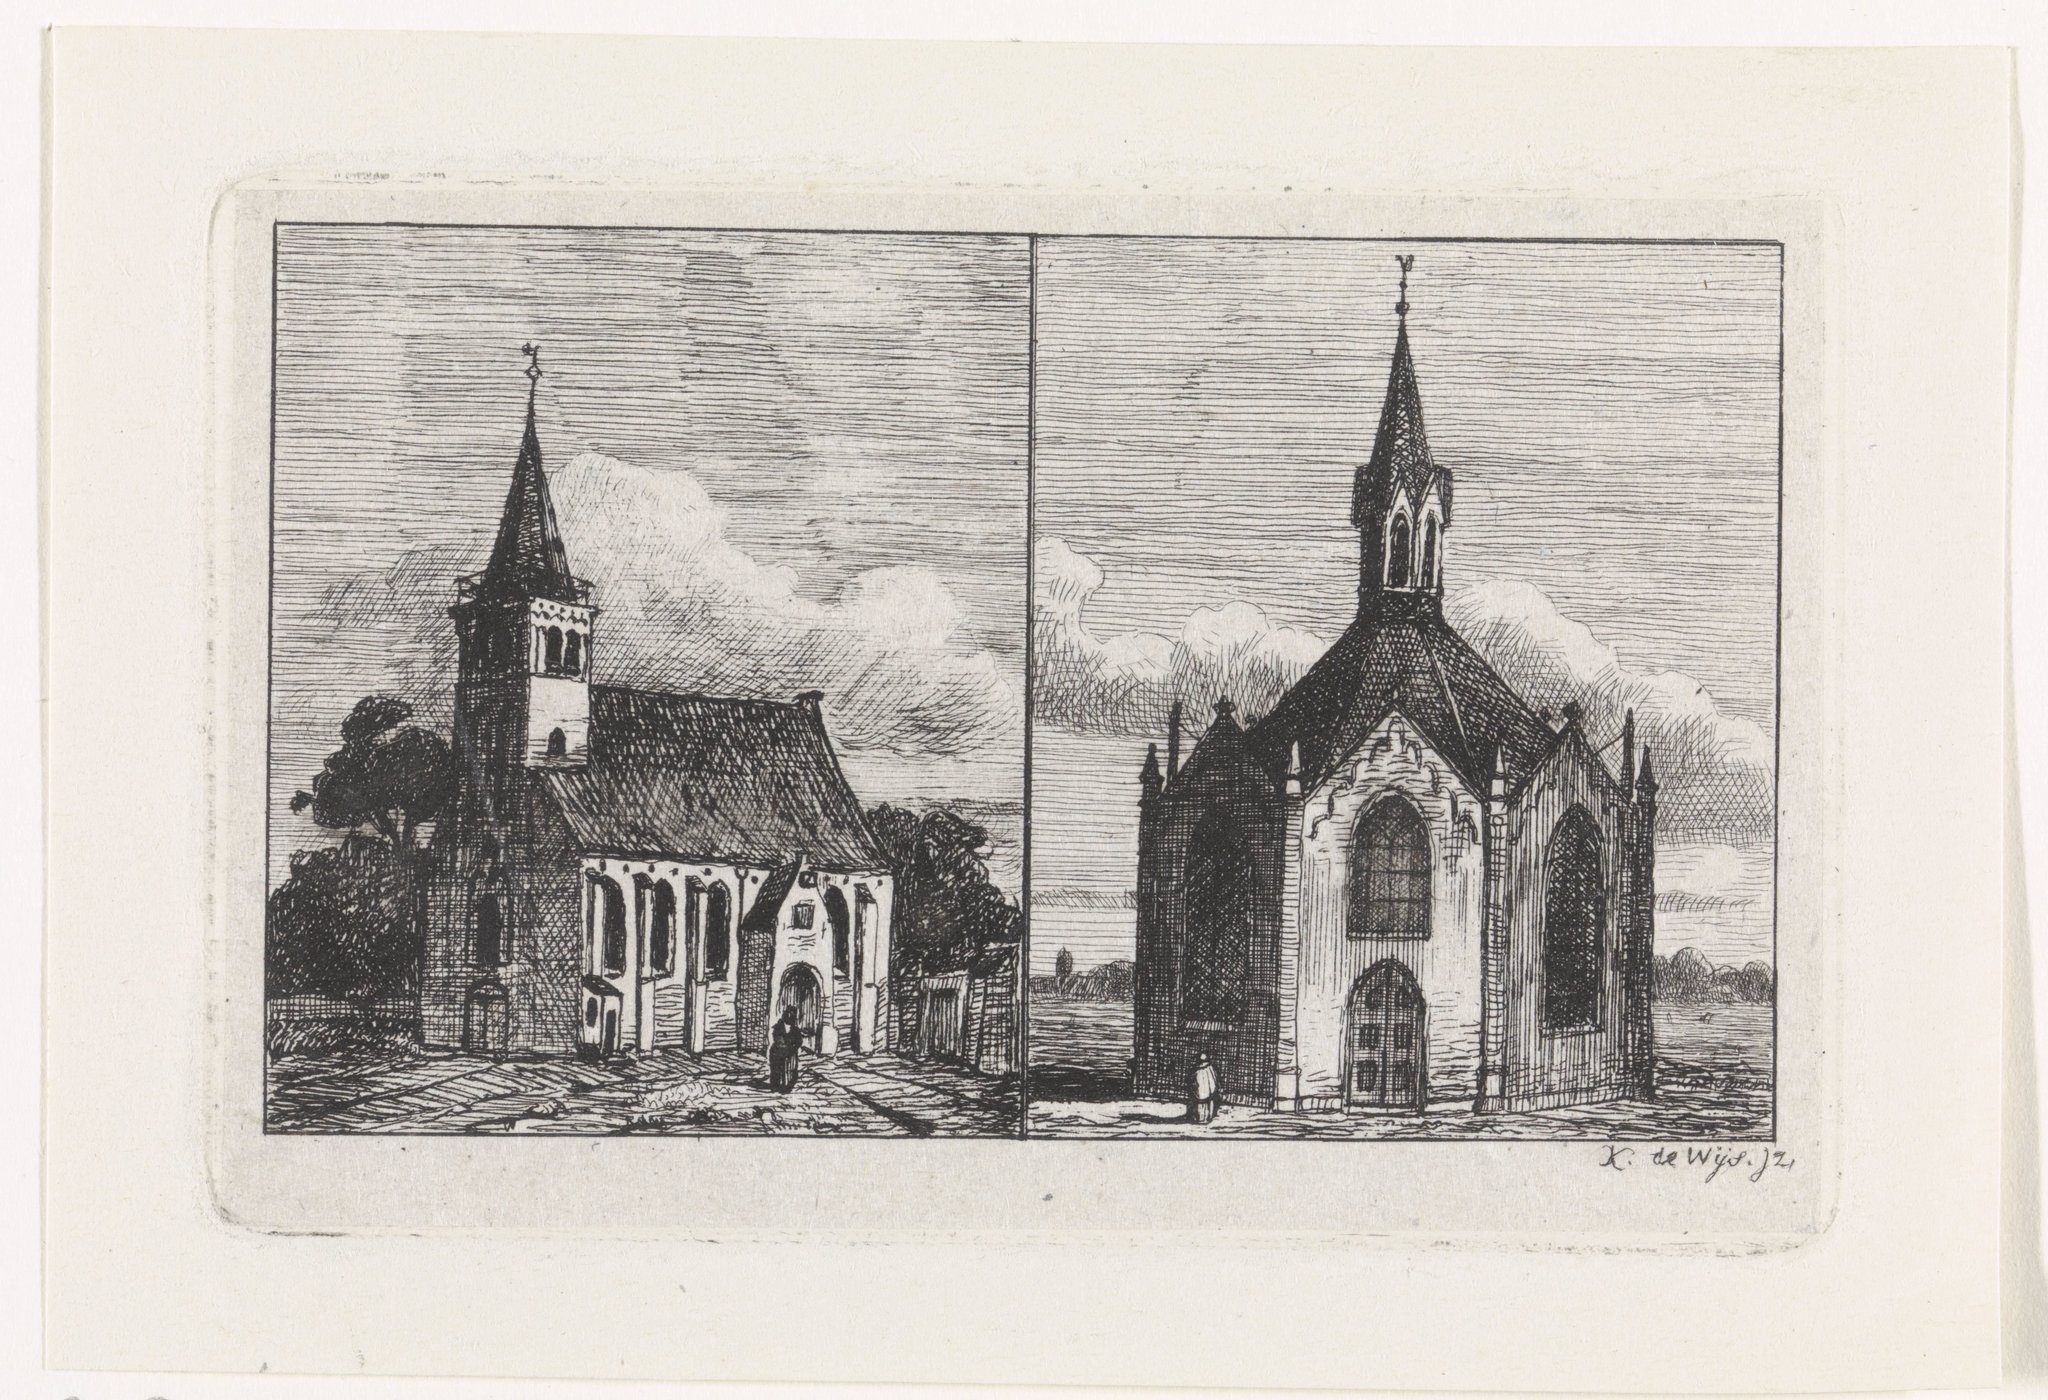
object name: print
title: Twee kerken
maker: kornelis jzn de wijs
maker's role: print maker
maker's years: 1832-1896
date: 1842-1884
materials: paper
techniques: etching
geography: netherlands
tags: church (exterior)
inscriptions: collector's mark: Lugt 2228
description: Links een kerk, omgeven door bomen en bij de ingang een vrouw. Rechts een koepelkerk.